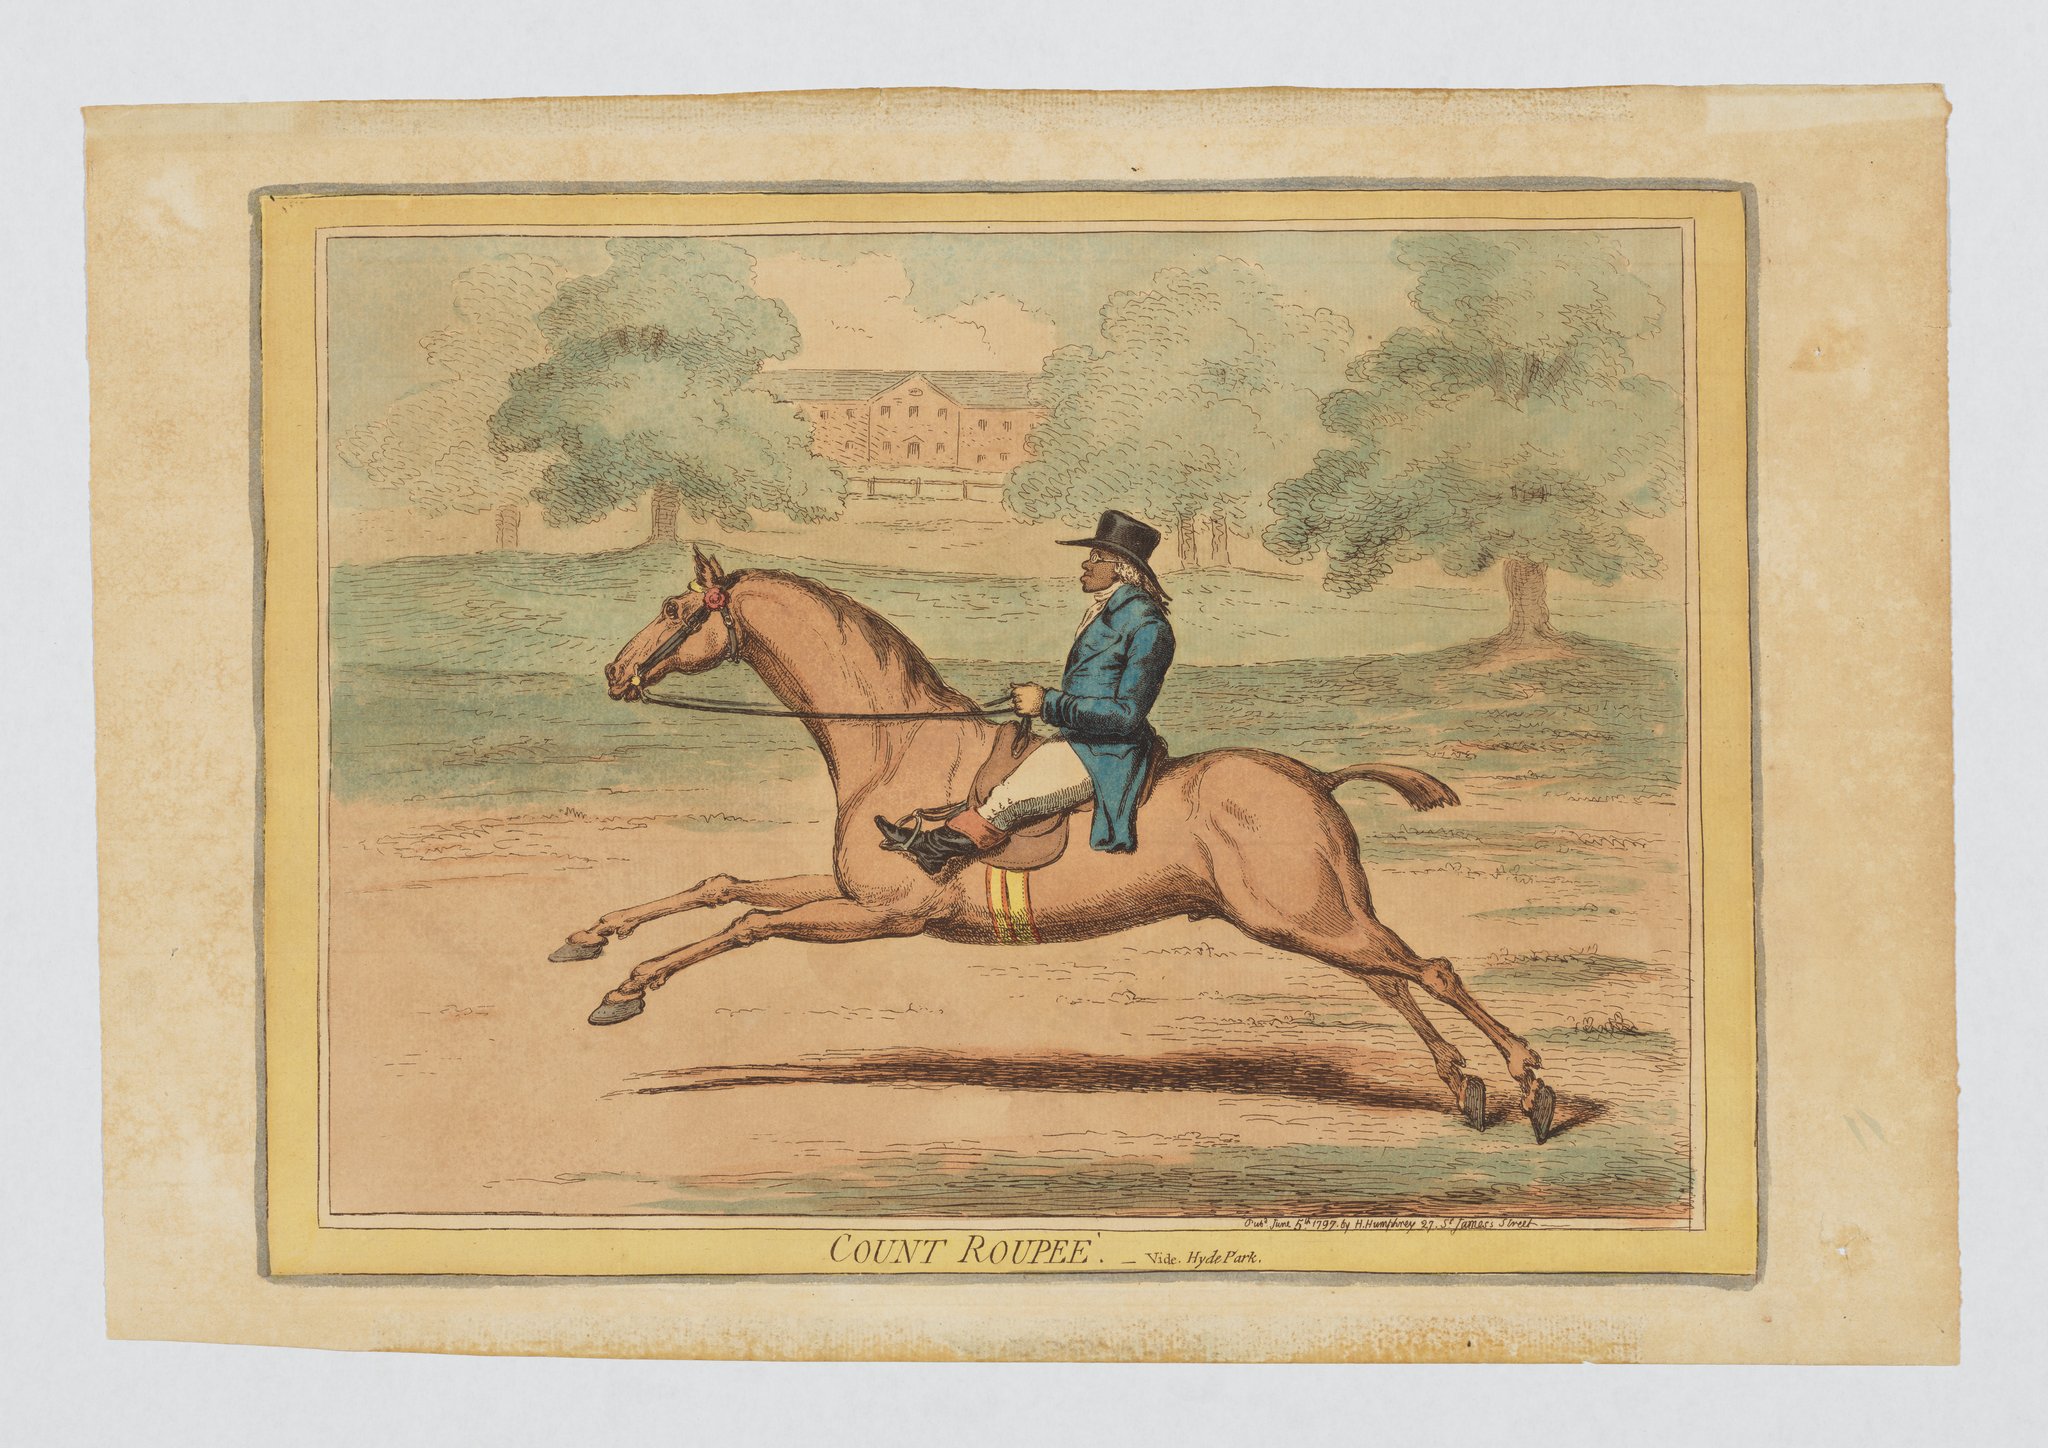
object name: print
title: Count Roupee -- Vide Hyde Park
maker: james gillray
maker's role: artist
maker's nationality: british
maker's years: 1756-1815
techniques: etching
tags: satire,men,horses